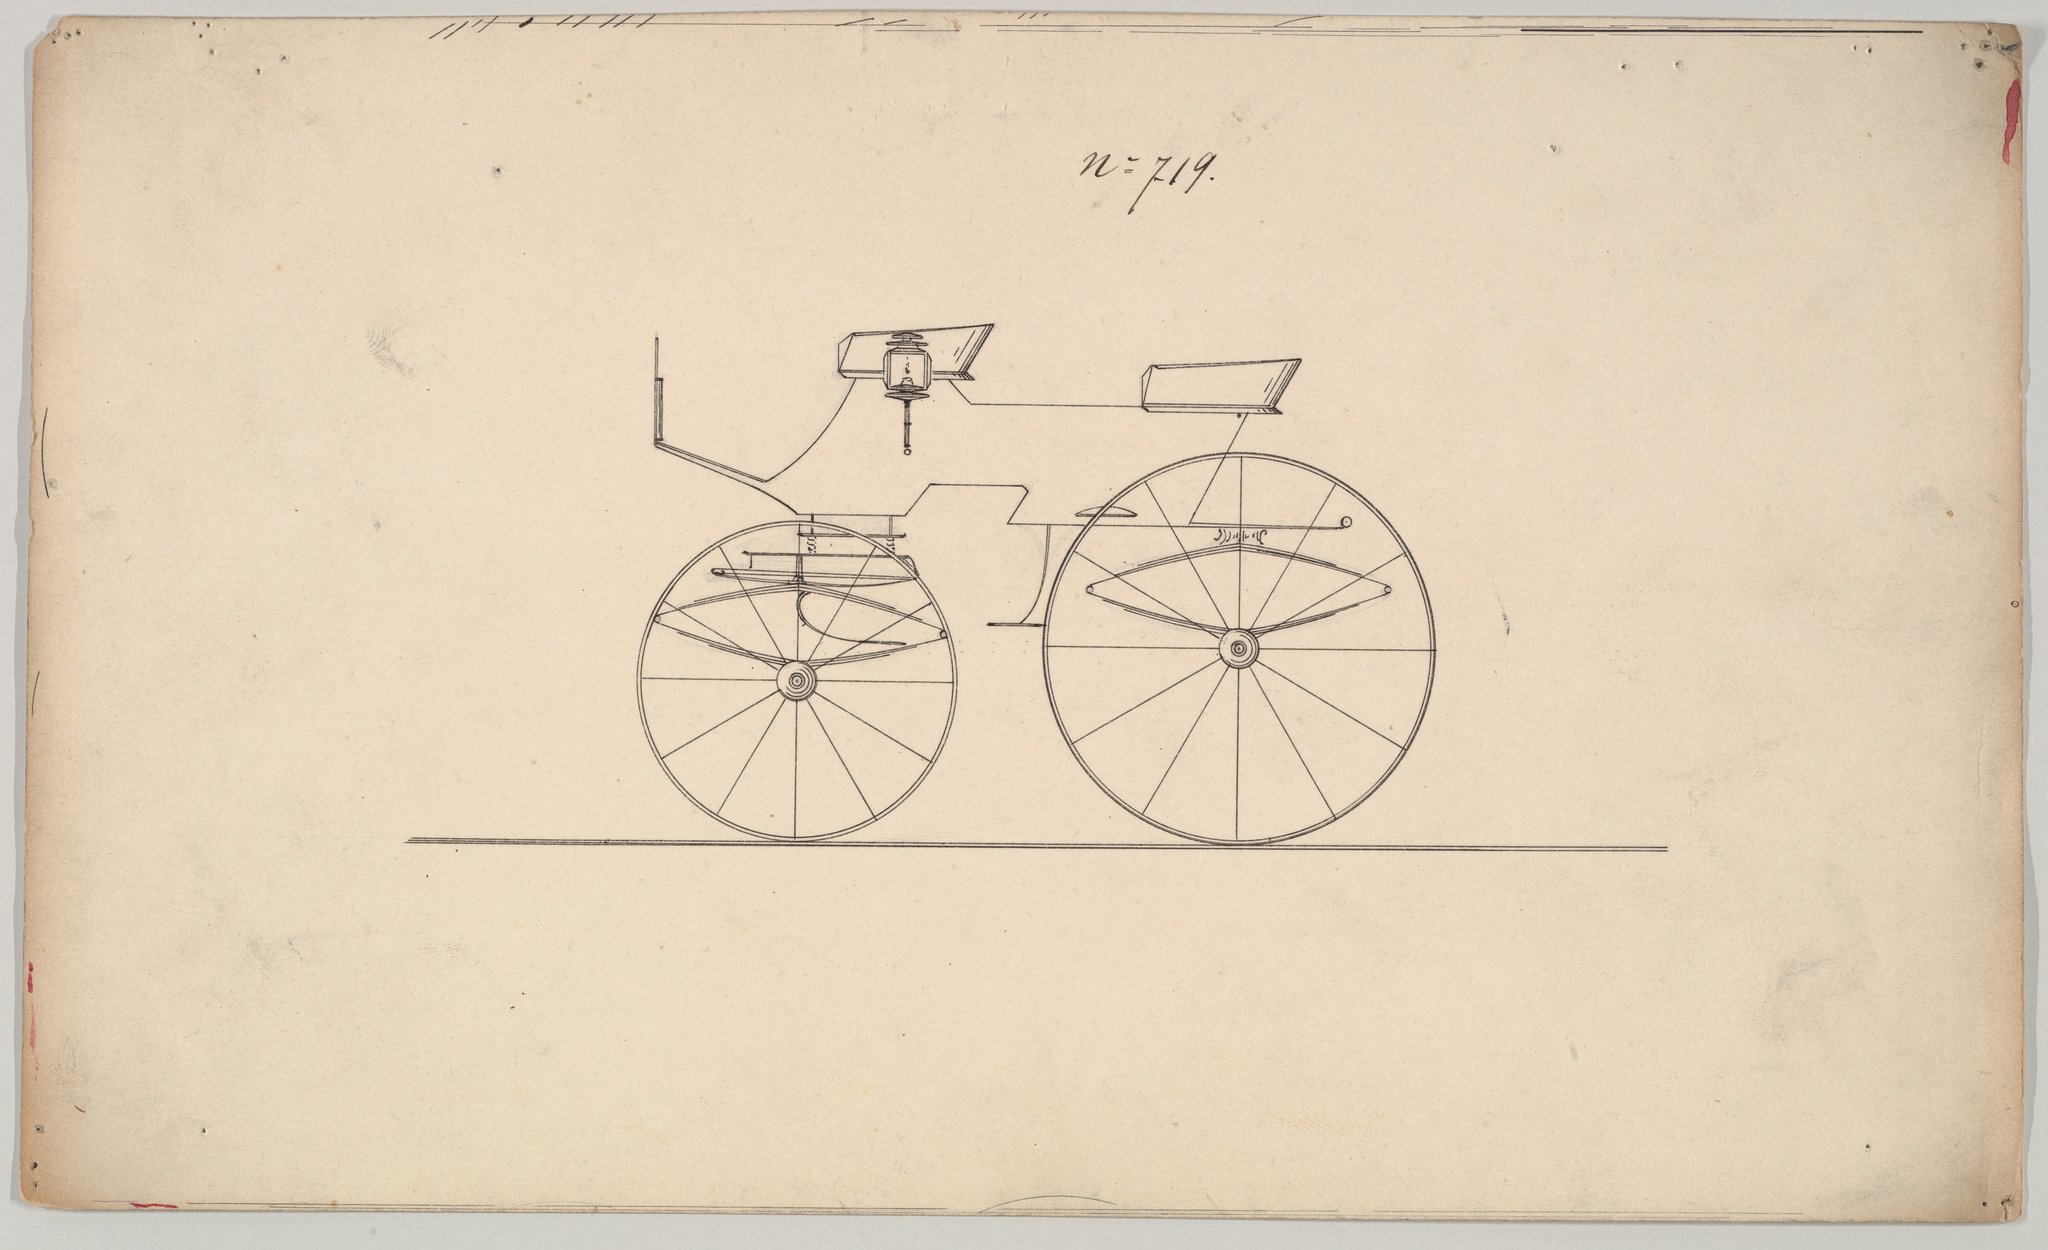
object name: drawing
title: Phaeton #719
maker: brewster & co.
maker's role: manufacturer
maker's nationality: american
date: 1850-1870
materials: ink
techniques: pen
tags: carriages